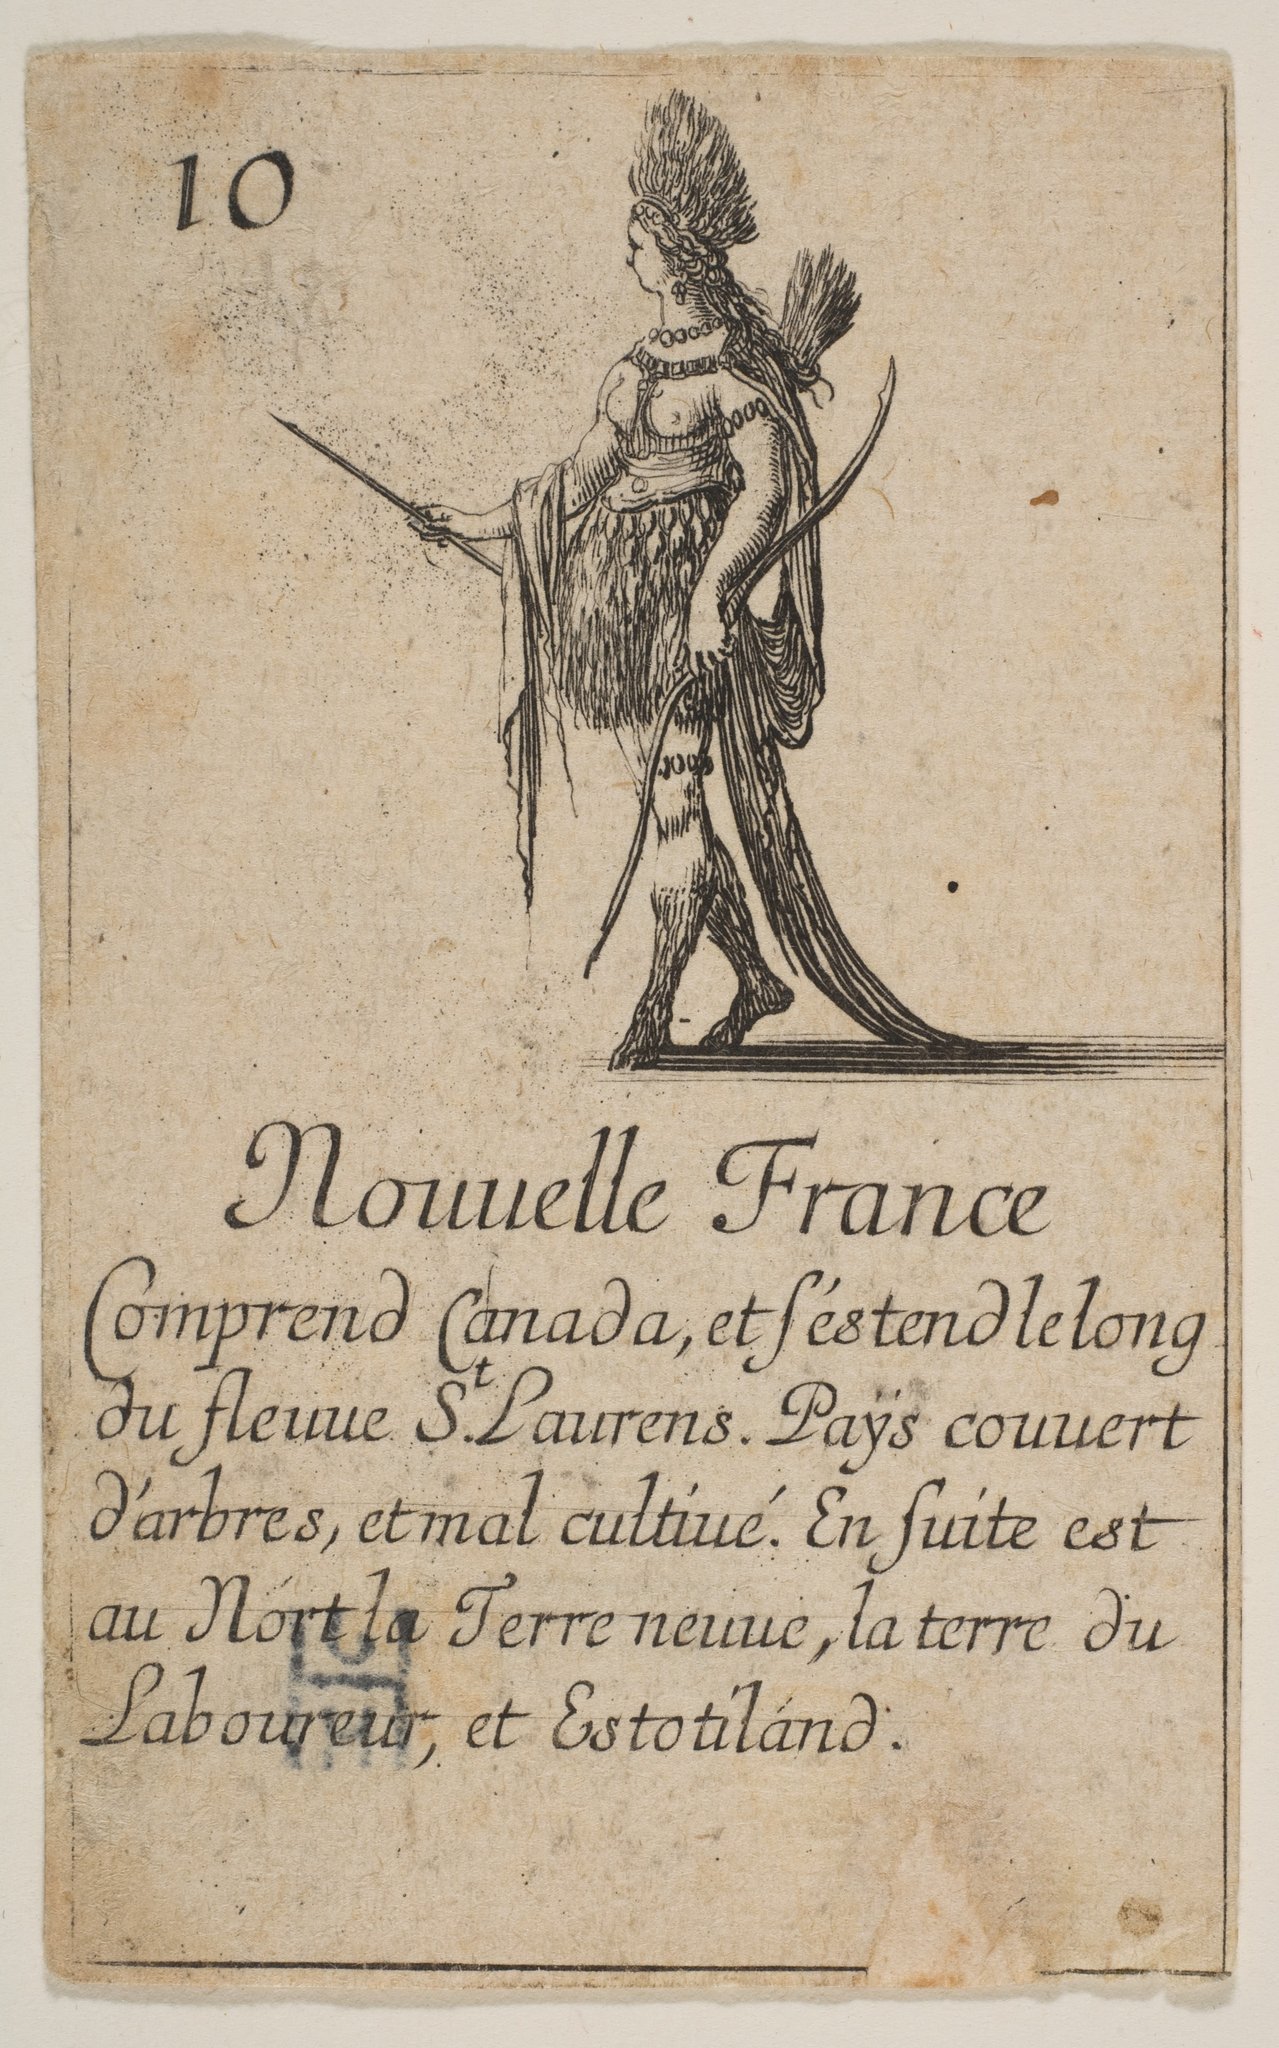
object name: print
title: New France, from the playing cards "Jeu de la Géographie"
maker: stefano della bella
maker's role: artist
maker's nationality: italian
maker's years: 1610-1664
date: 1644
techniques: etching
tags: women